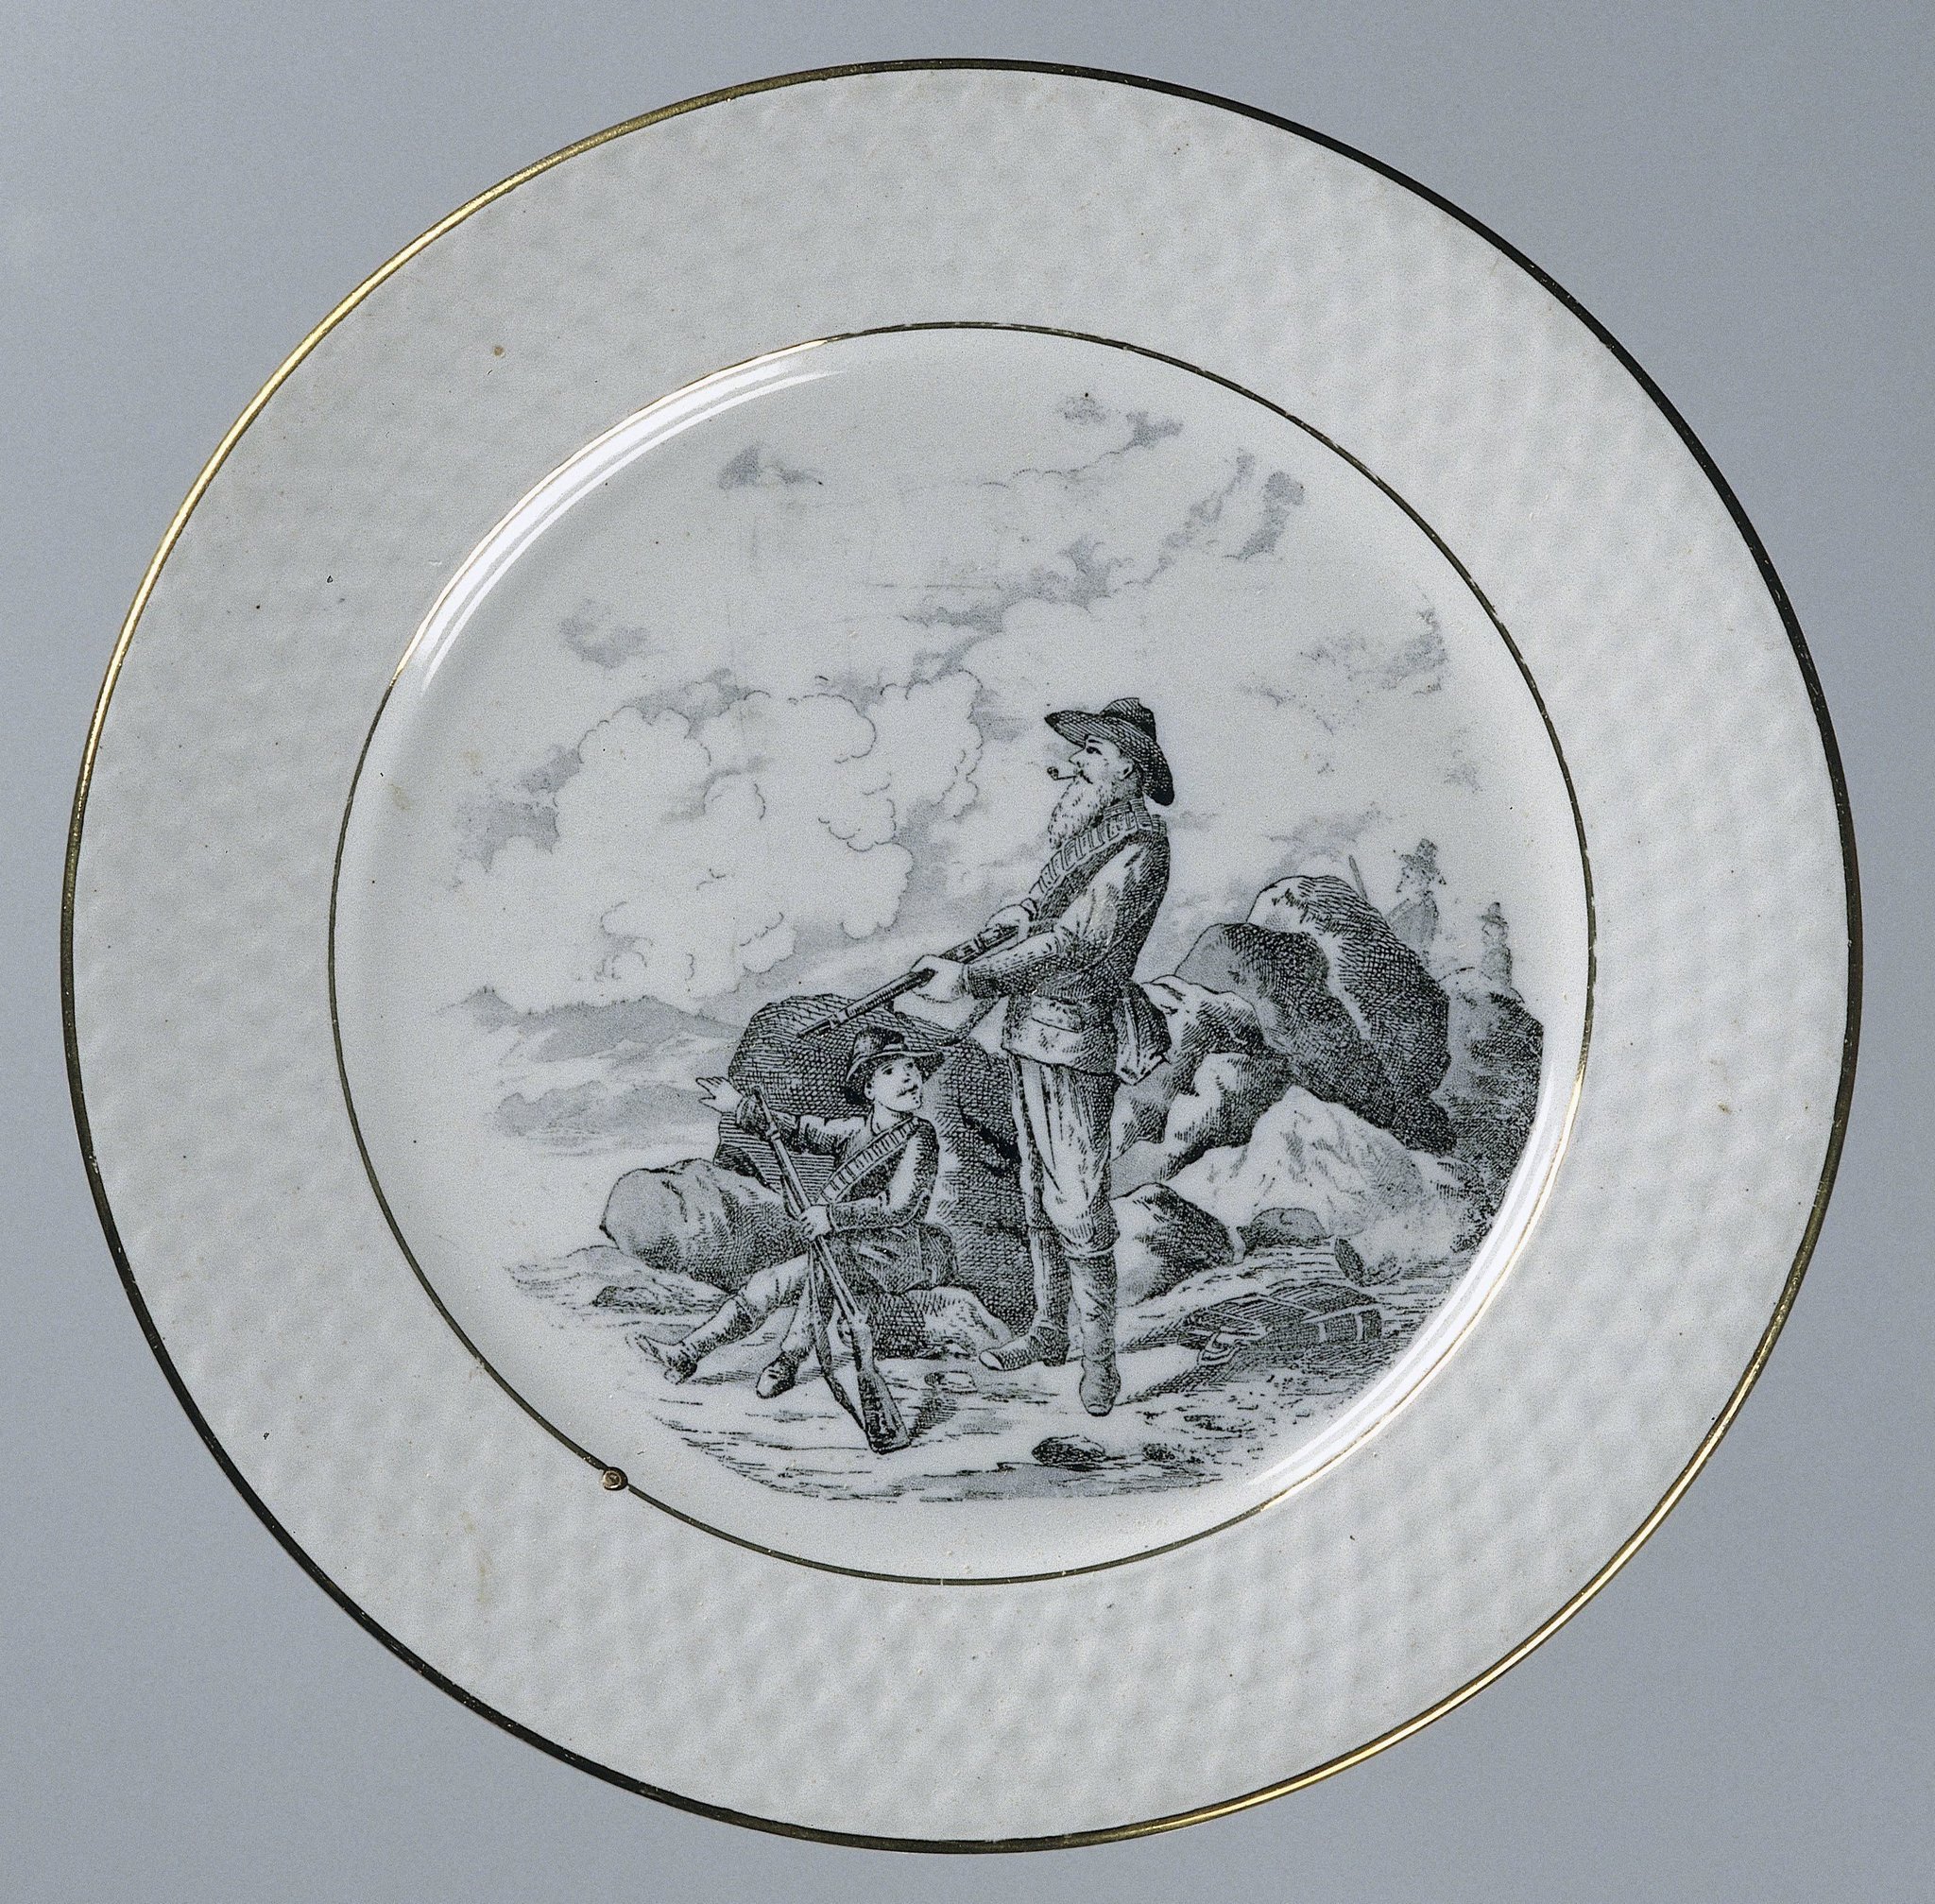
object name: plate dish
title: Herinneringsbord Boerenoorlog: twee mannen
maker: Anonymous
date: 1899-1925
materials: earthenware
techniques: firing, printing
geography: south africa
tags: battle, fighting in general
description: Commemorative plates with scenes from the Boer War. Earthenware, c. 1910. Made by Petrus Regout, Maastricht. Sympathy for the Boers was so strong in Holland that the memory of the war continued to live on for many years. Particularly popular were the various Afrikaner songs, as well as plates such as these.